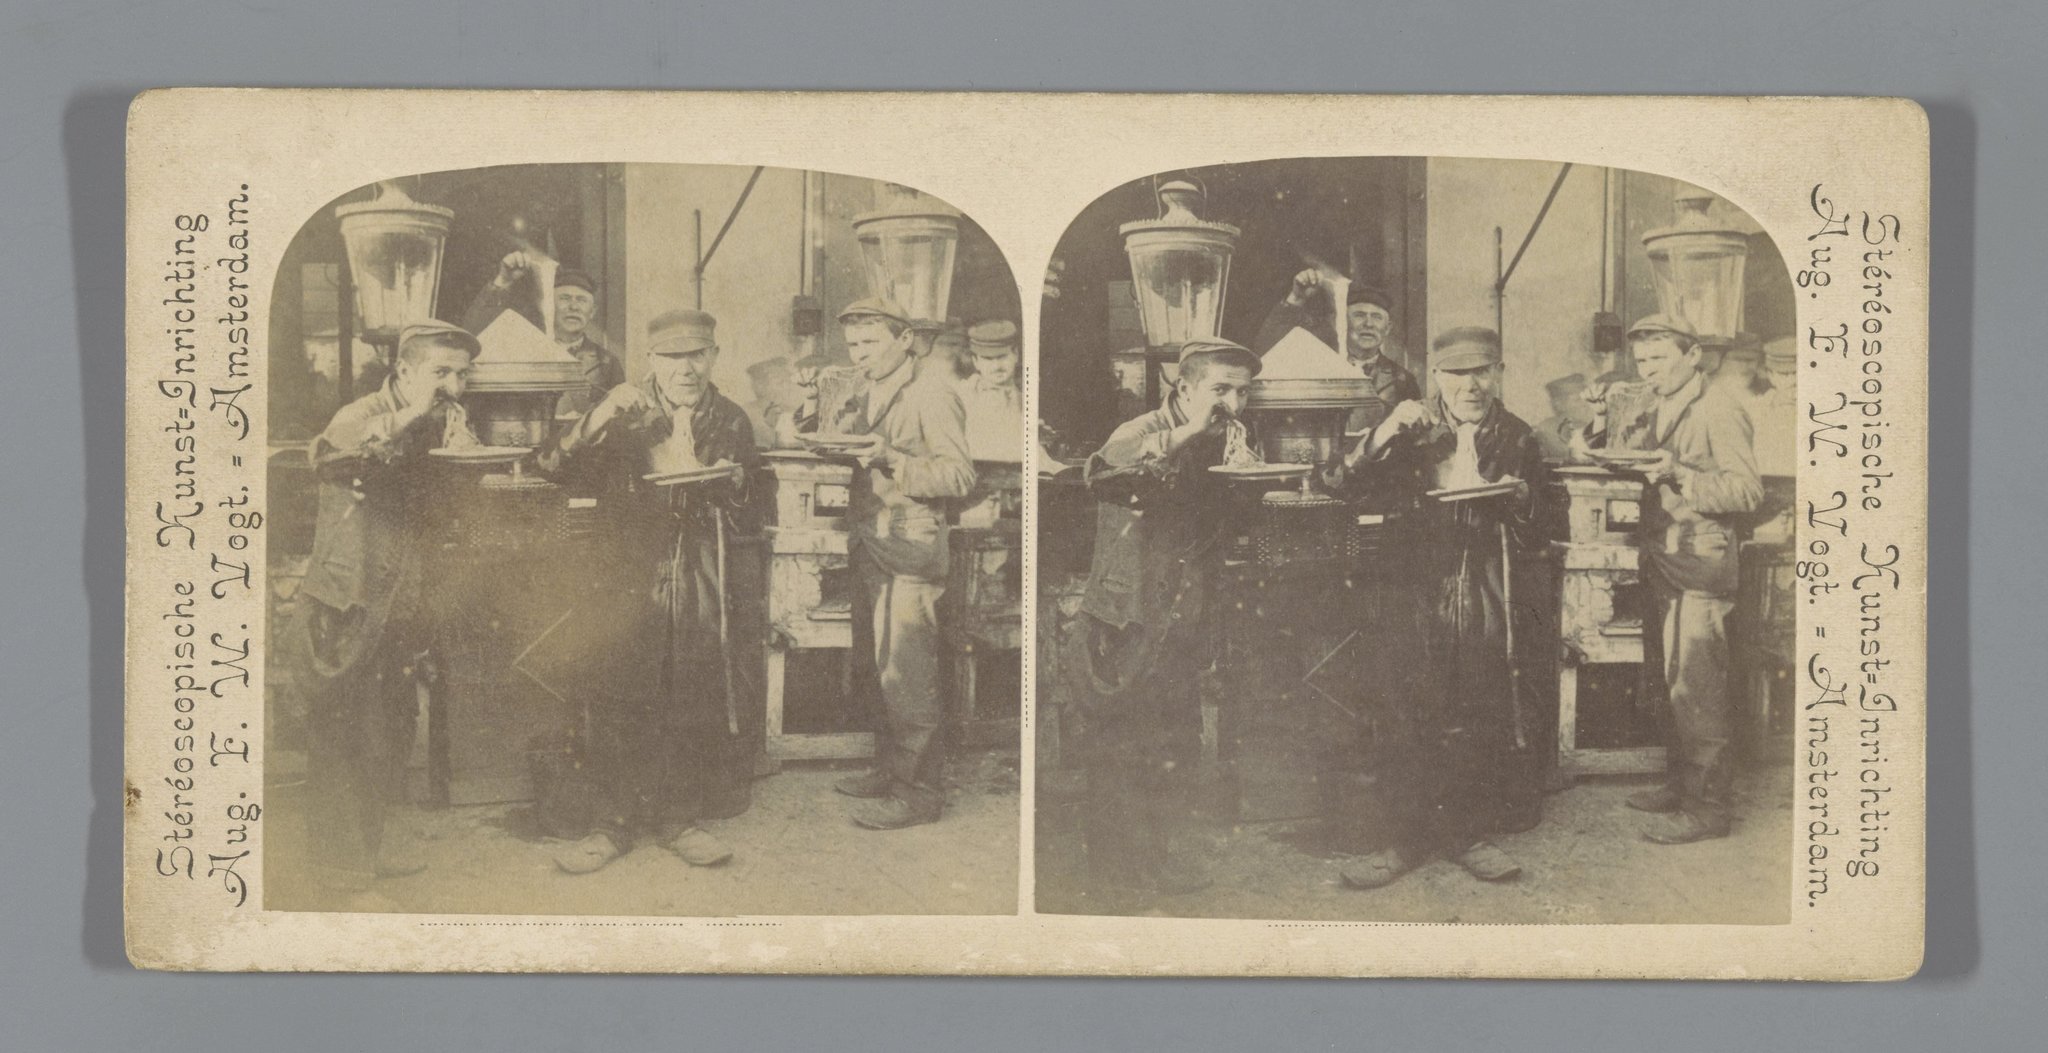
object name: stereograph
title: Drie mannen eten spaghetti bij kraam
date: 1870-1910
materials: cardboard, photographic support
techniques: albumen print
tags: noodles, spaghetti, etc., stall, booth (~ market), lighting; lamps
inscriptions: : ‘Stéréoscopische Kunst-Inrichting, Amsterdam’